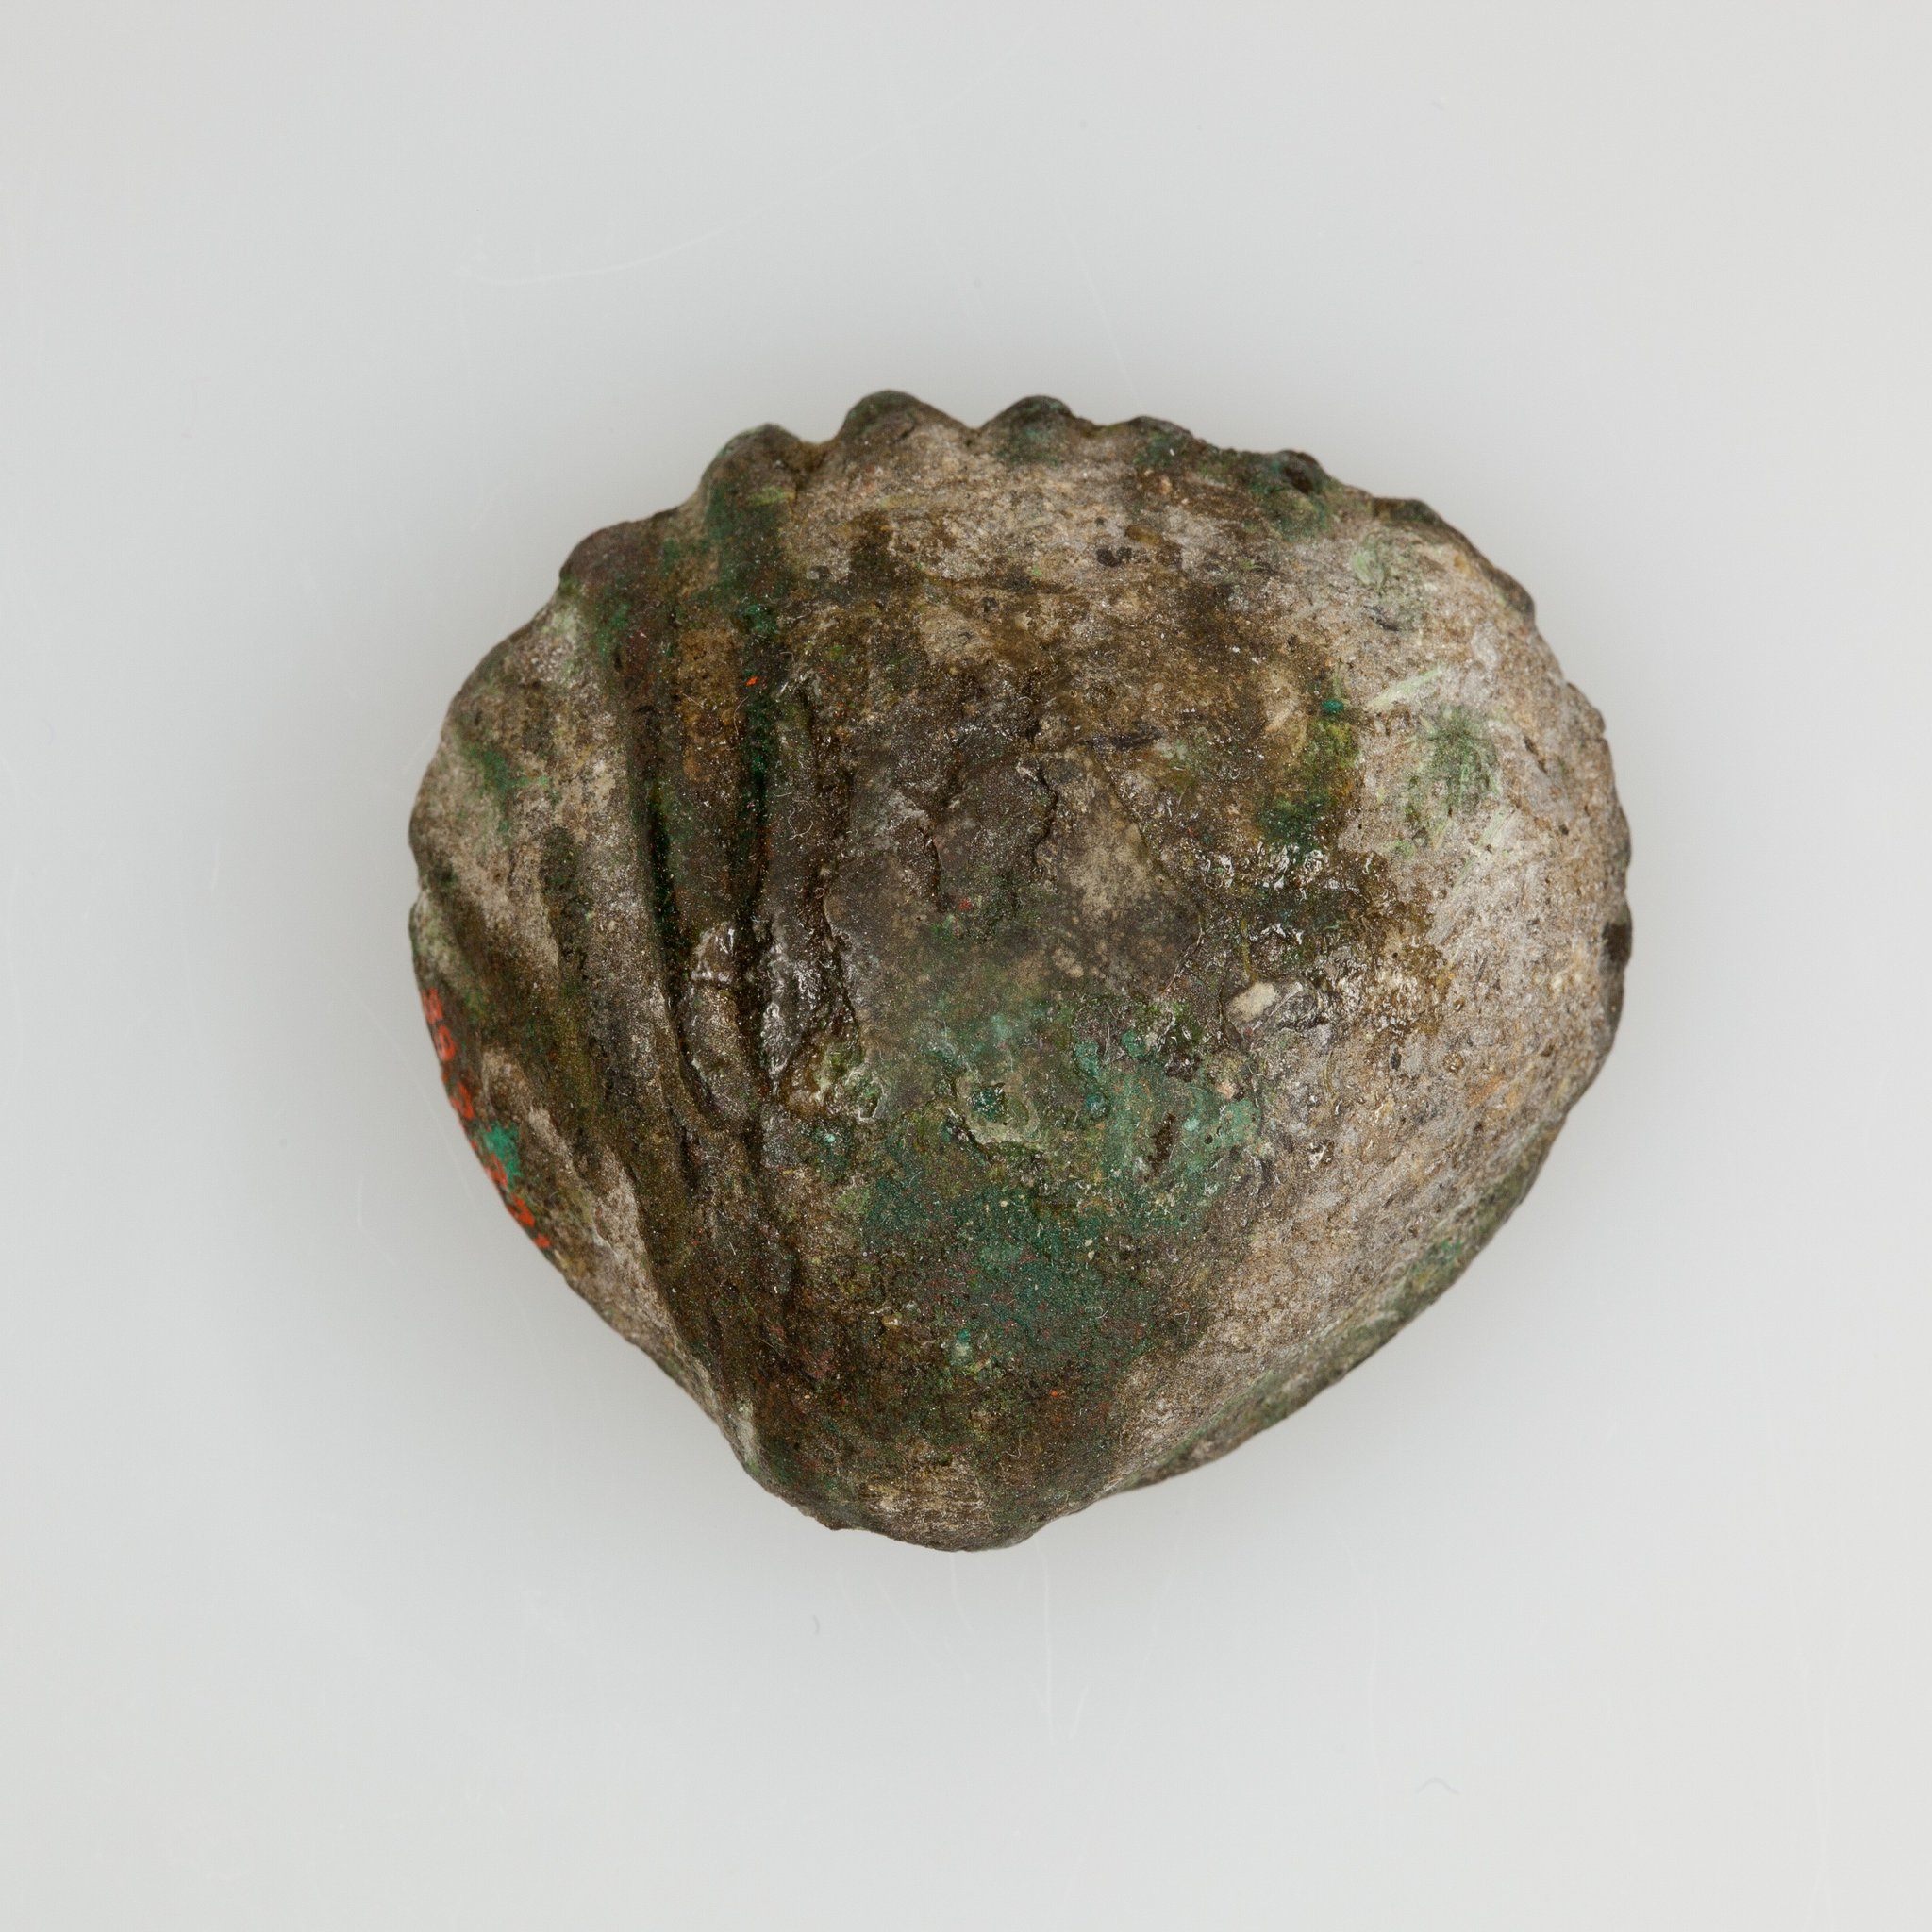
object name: model shell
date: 306-30 BCE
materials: copper alloy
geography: egypt